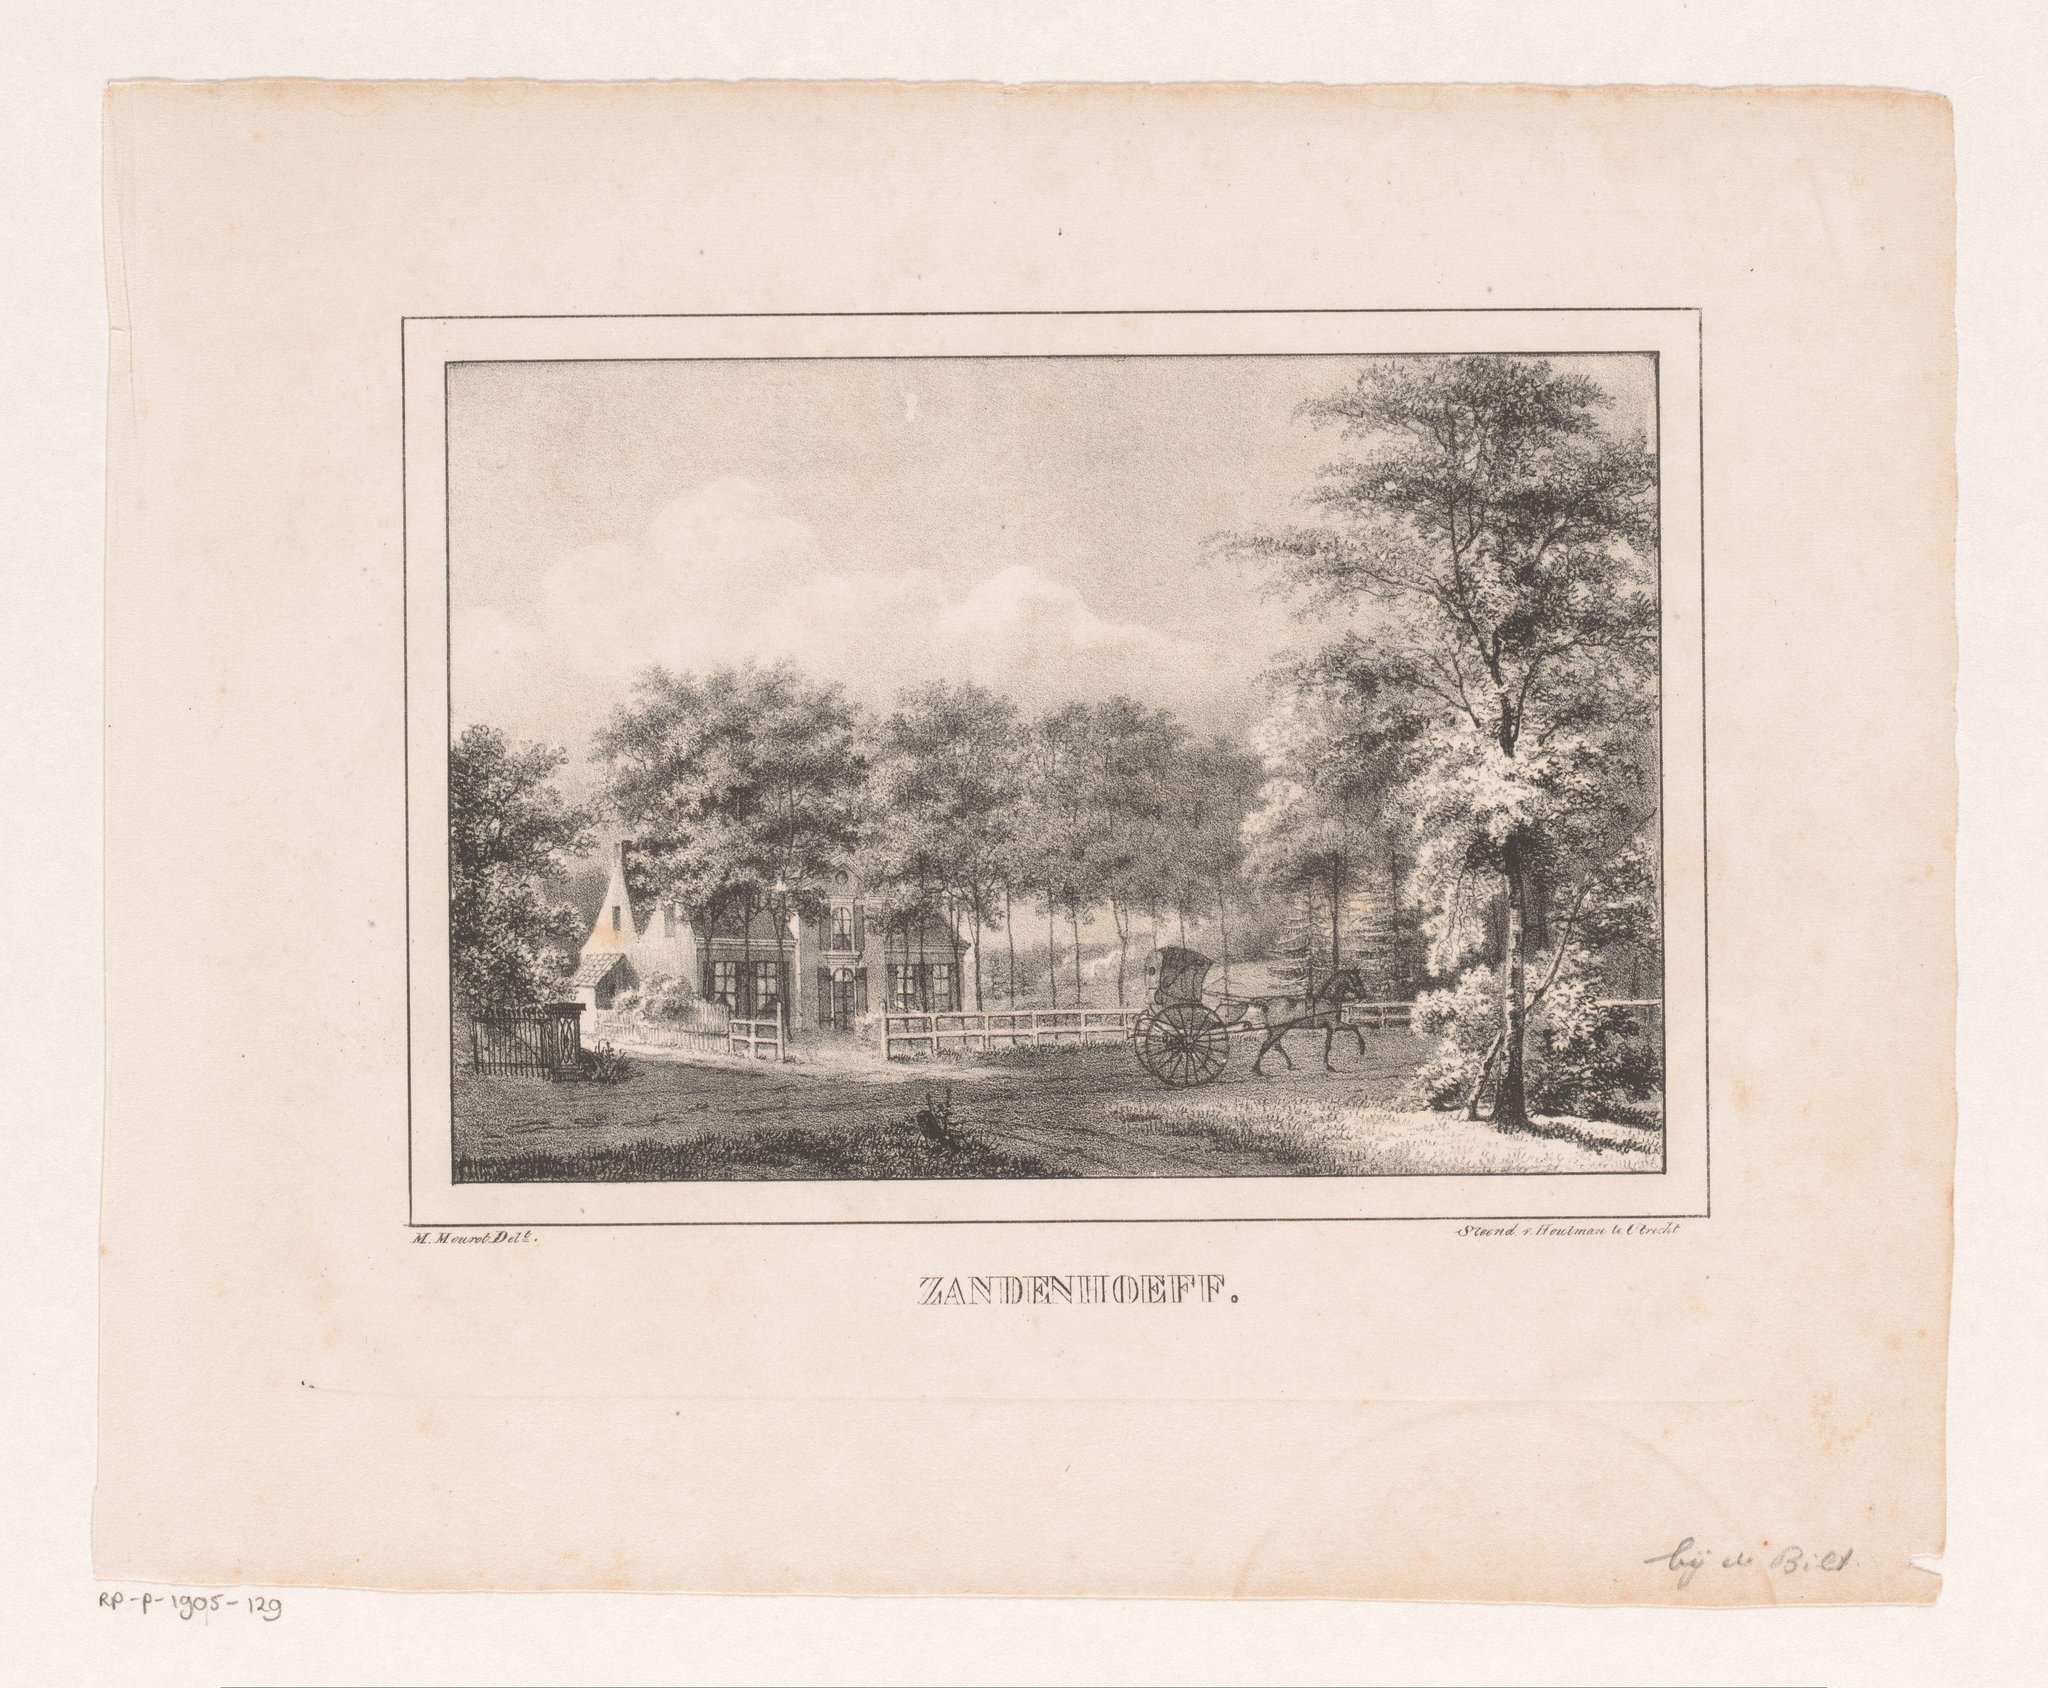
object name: print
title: Zandenhoeff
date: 1829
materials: paper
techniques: lithograph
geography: utrecht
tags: two-wheeled vehicle drawn by one animal, farm or solitary house in landscape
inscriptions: collector's mark: Lugt 2228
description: Uitgegeven in: Gezigten van buitenplaatsen en gebouwen gelegen tusschen de Stad Utrecht en de Grebbe. Utrecht, I. P. Houtman: 1829.